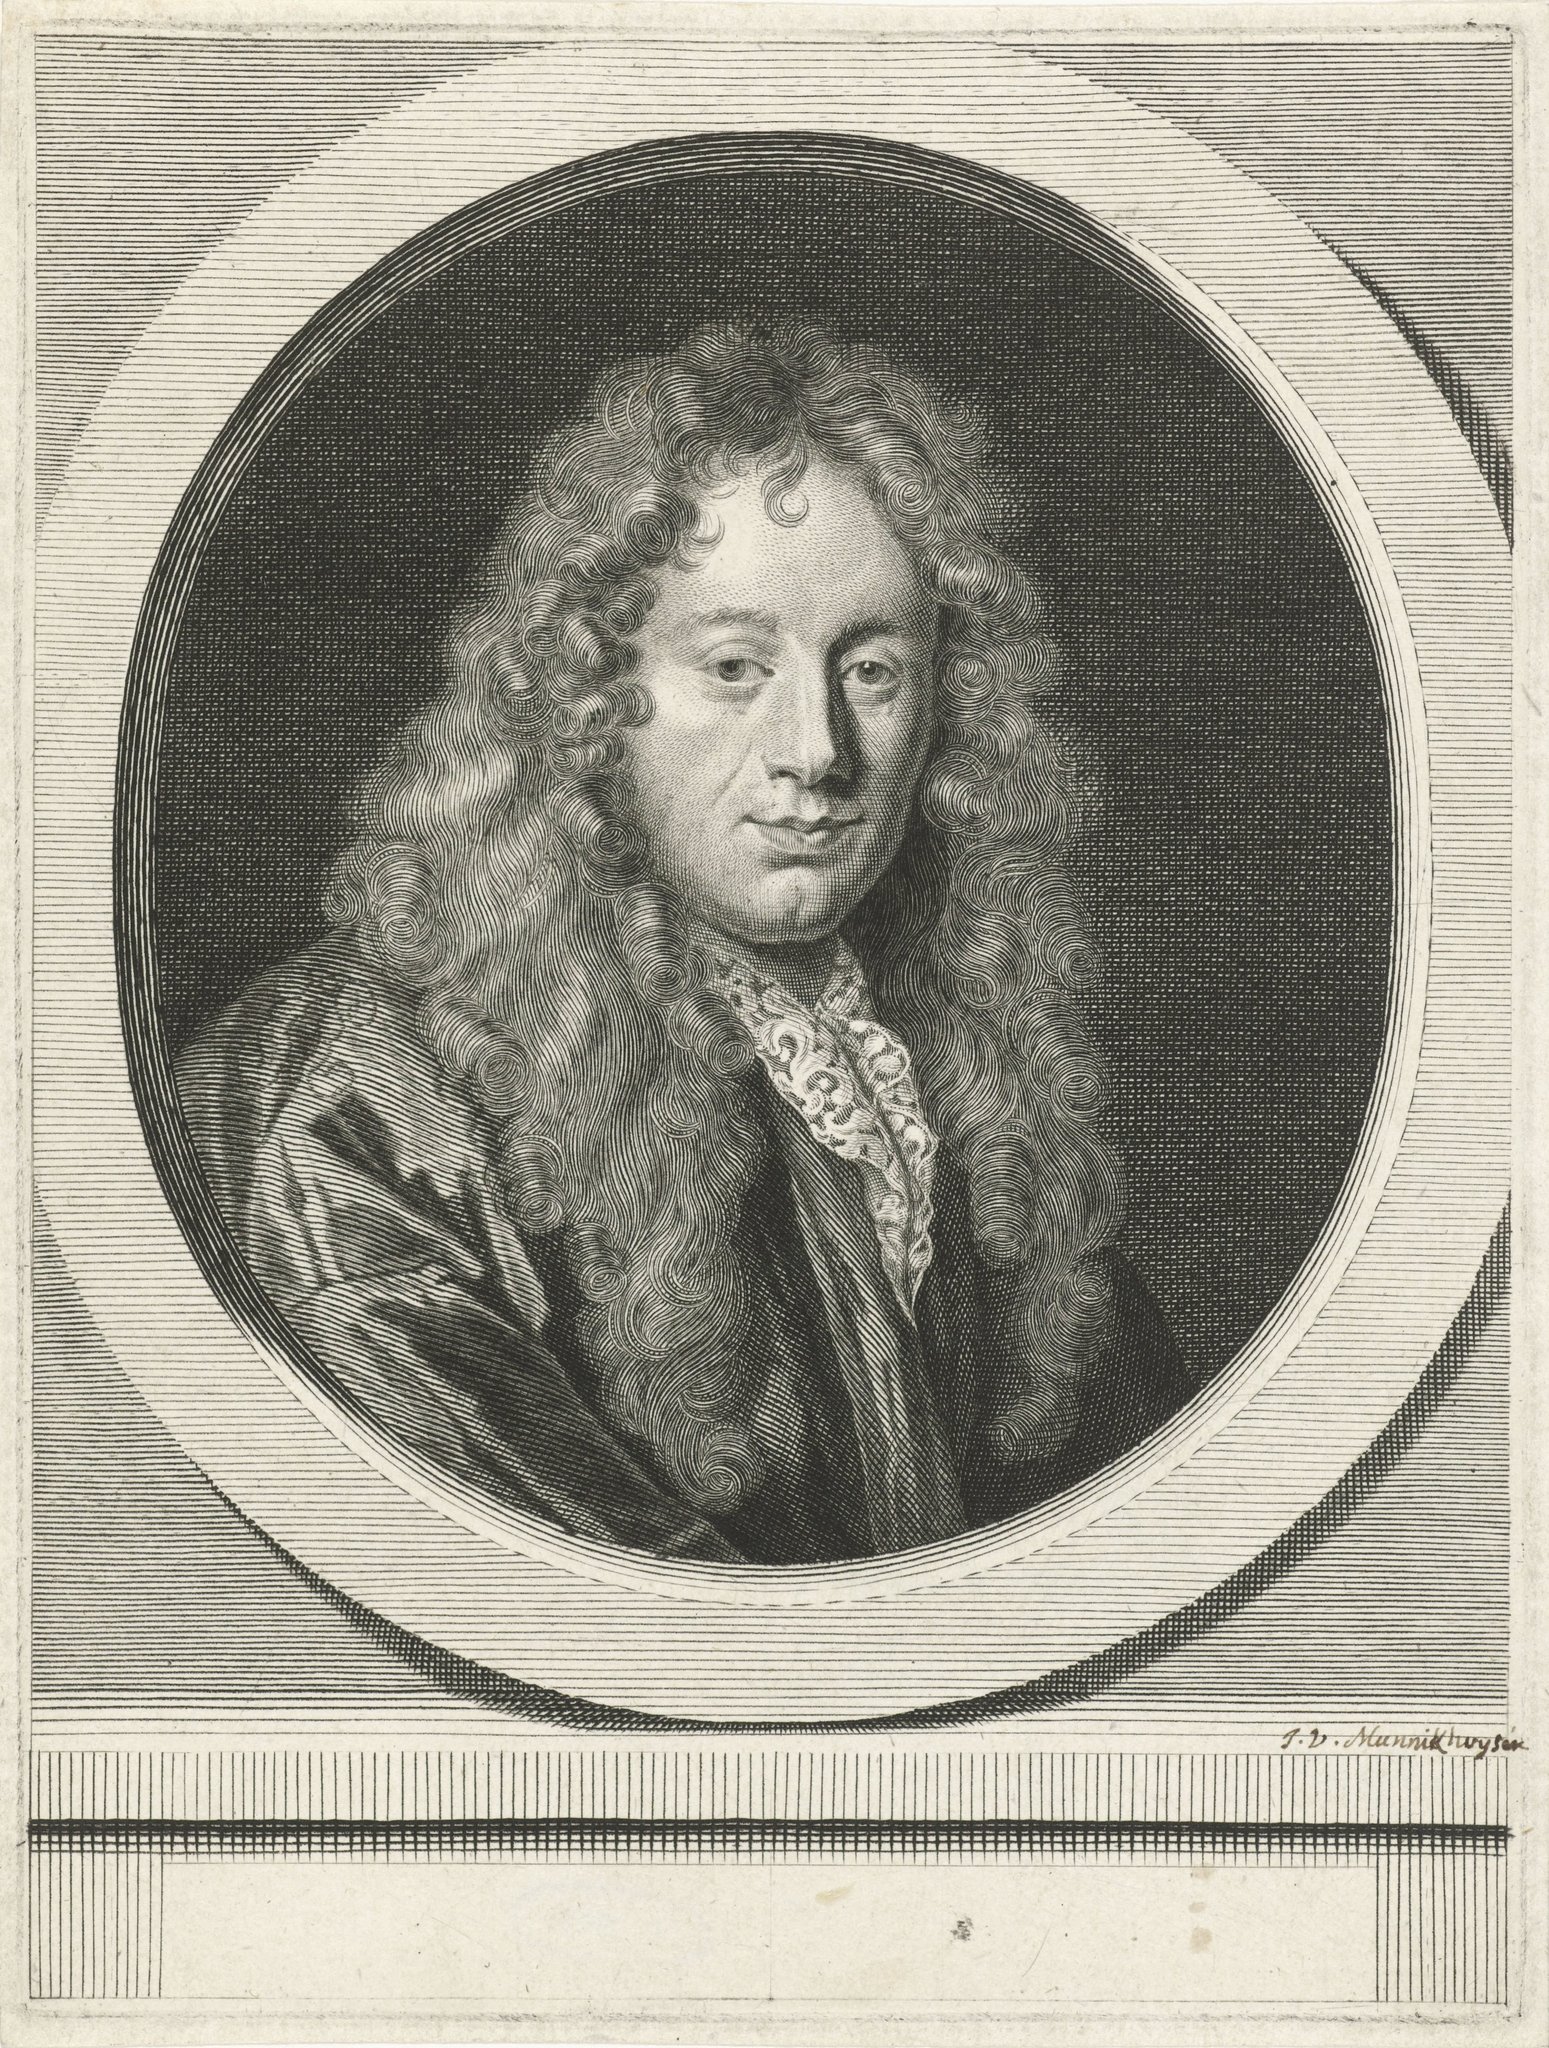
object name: print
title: Portret van Hermanus Neuspitzer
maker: jan van munnickhuysen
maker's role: draughtsman, print maker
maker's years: 1655-1701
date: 1677-1721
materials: paper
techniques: engraving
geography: netherlands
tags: dordrecht, hermanus neuspitzer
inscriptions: collector's mark: Lugt 2228, inscription: ‘j.v.Munnikhuysen’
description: Portret van Hermanus Neuspitzer, rector van de Latijnse School te Dordrecht.